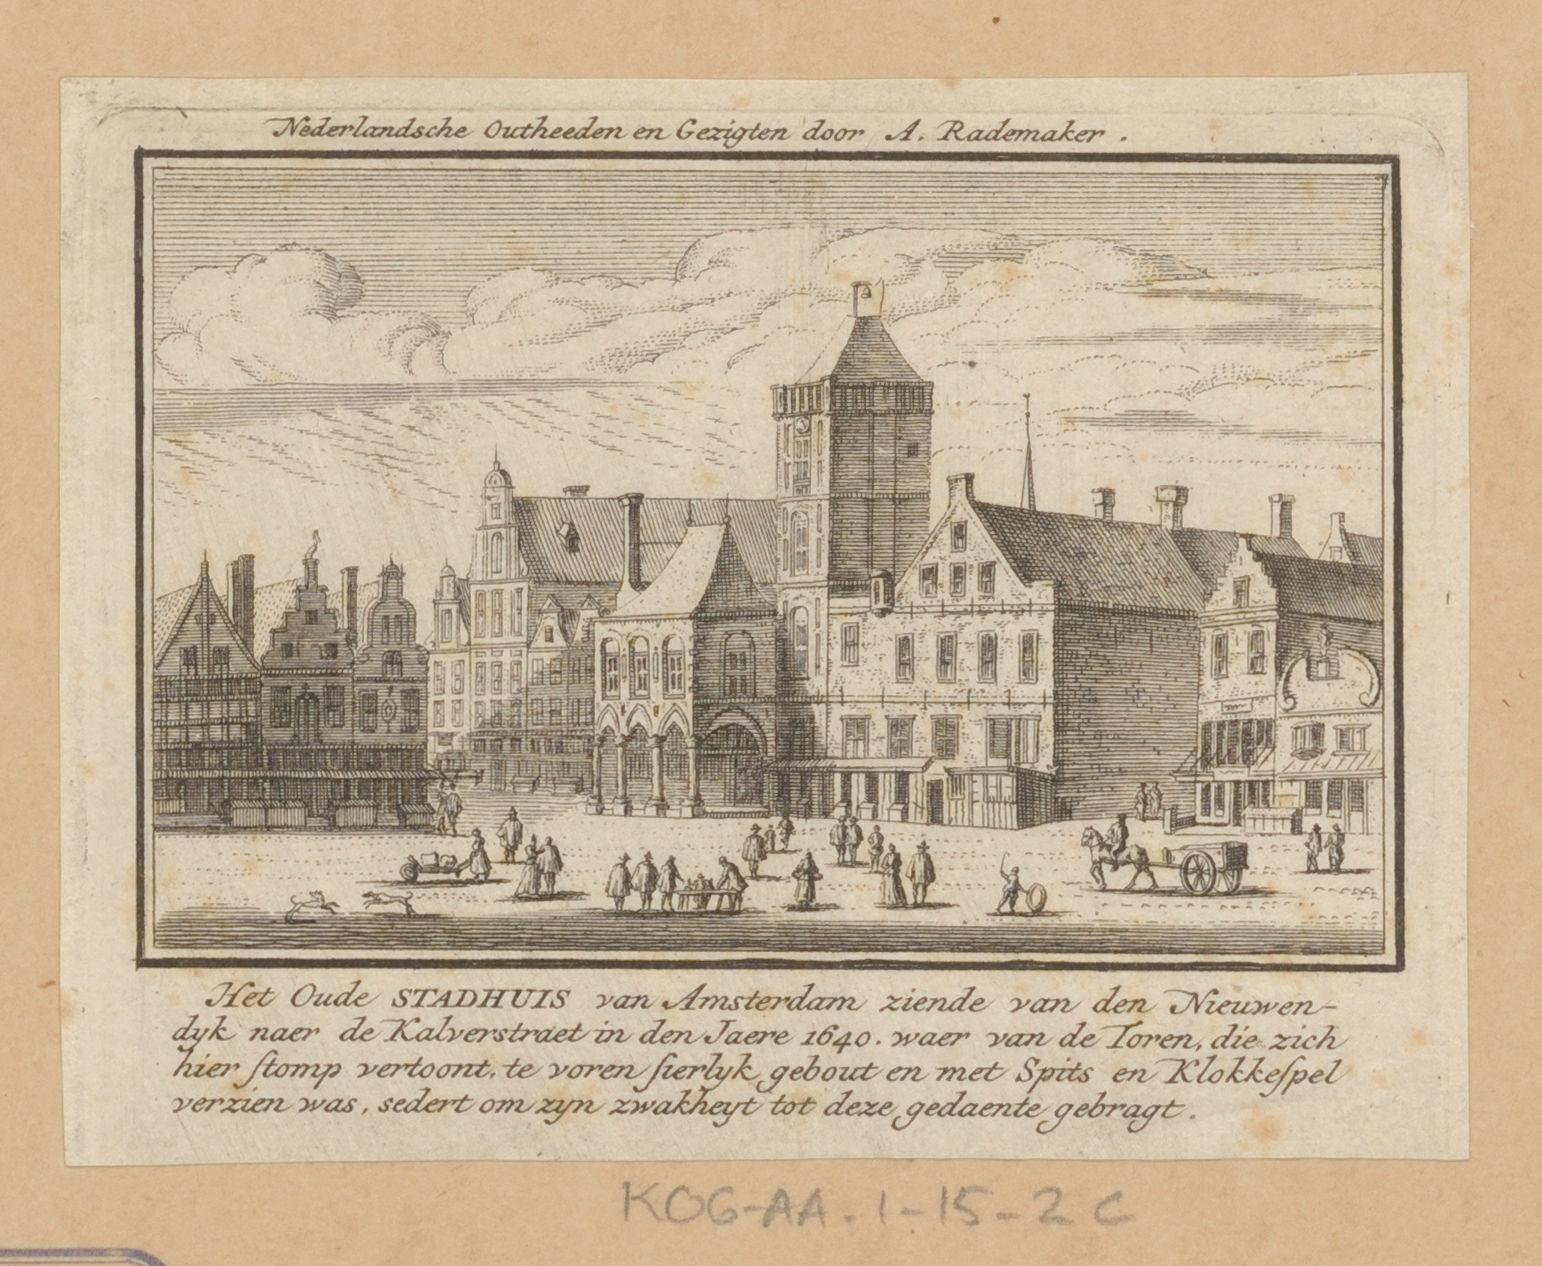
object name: print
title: Gezicht op het oude stadhuis van Amsterdam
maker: abraham rademaker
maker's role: draughtsman, print maker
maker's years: 1676-1735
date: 1726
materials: paper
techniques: etching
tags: square, place, circus, etc., city-view in general; 'veduta', townhall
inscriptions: collector's mark: ‘15,2 B-D’ Lugt 1641b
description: Prent waarschijnlijk uit: Rademaker, Abraham en I.M. Bregmagher. Versameling van 100 Nederlantsche outheden en gesigten. Amsterdam: Ysack Greve, 1726.